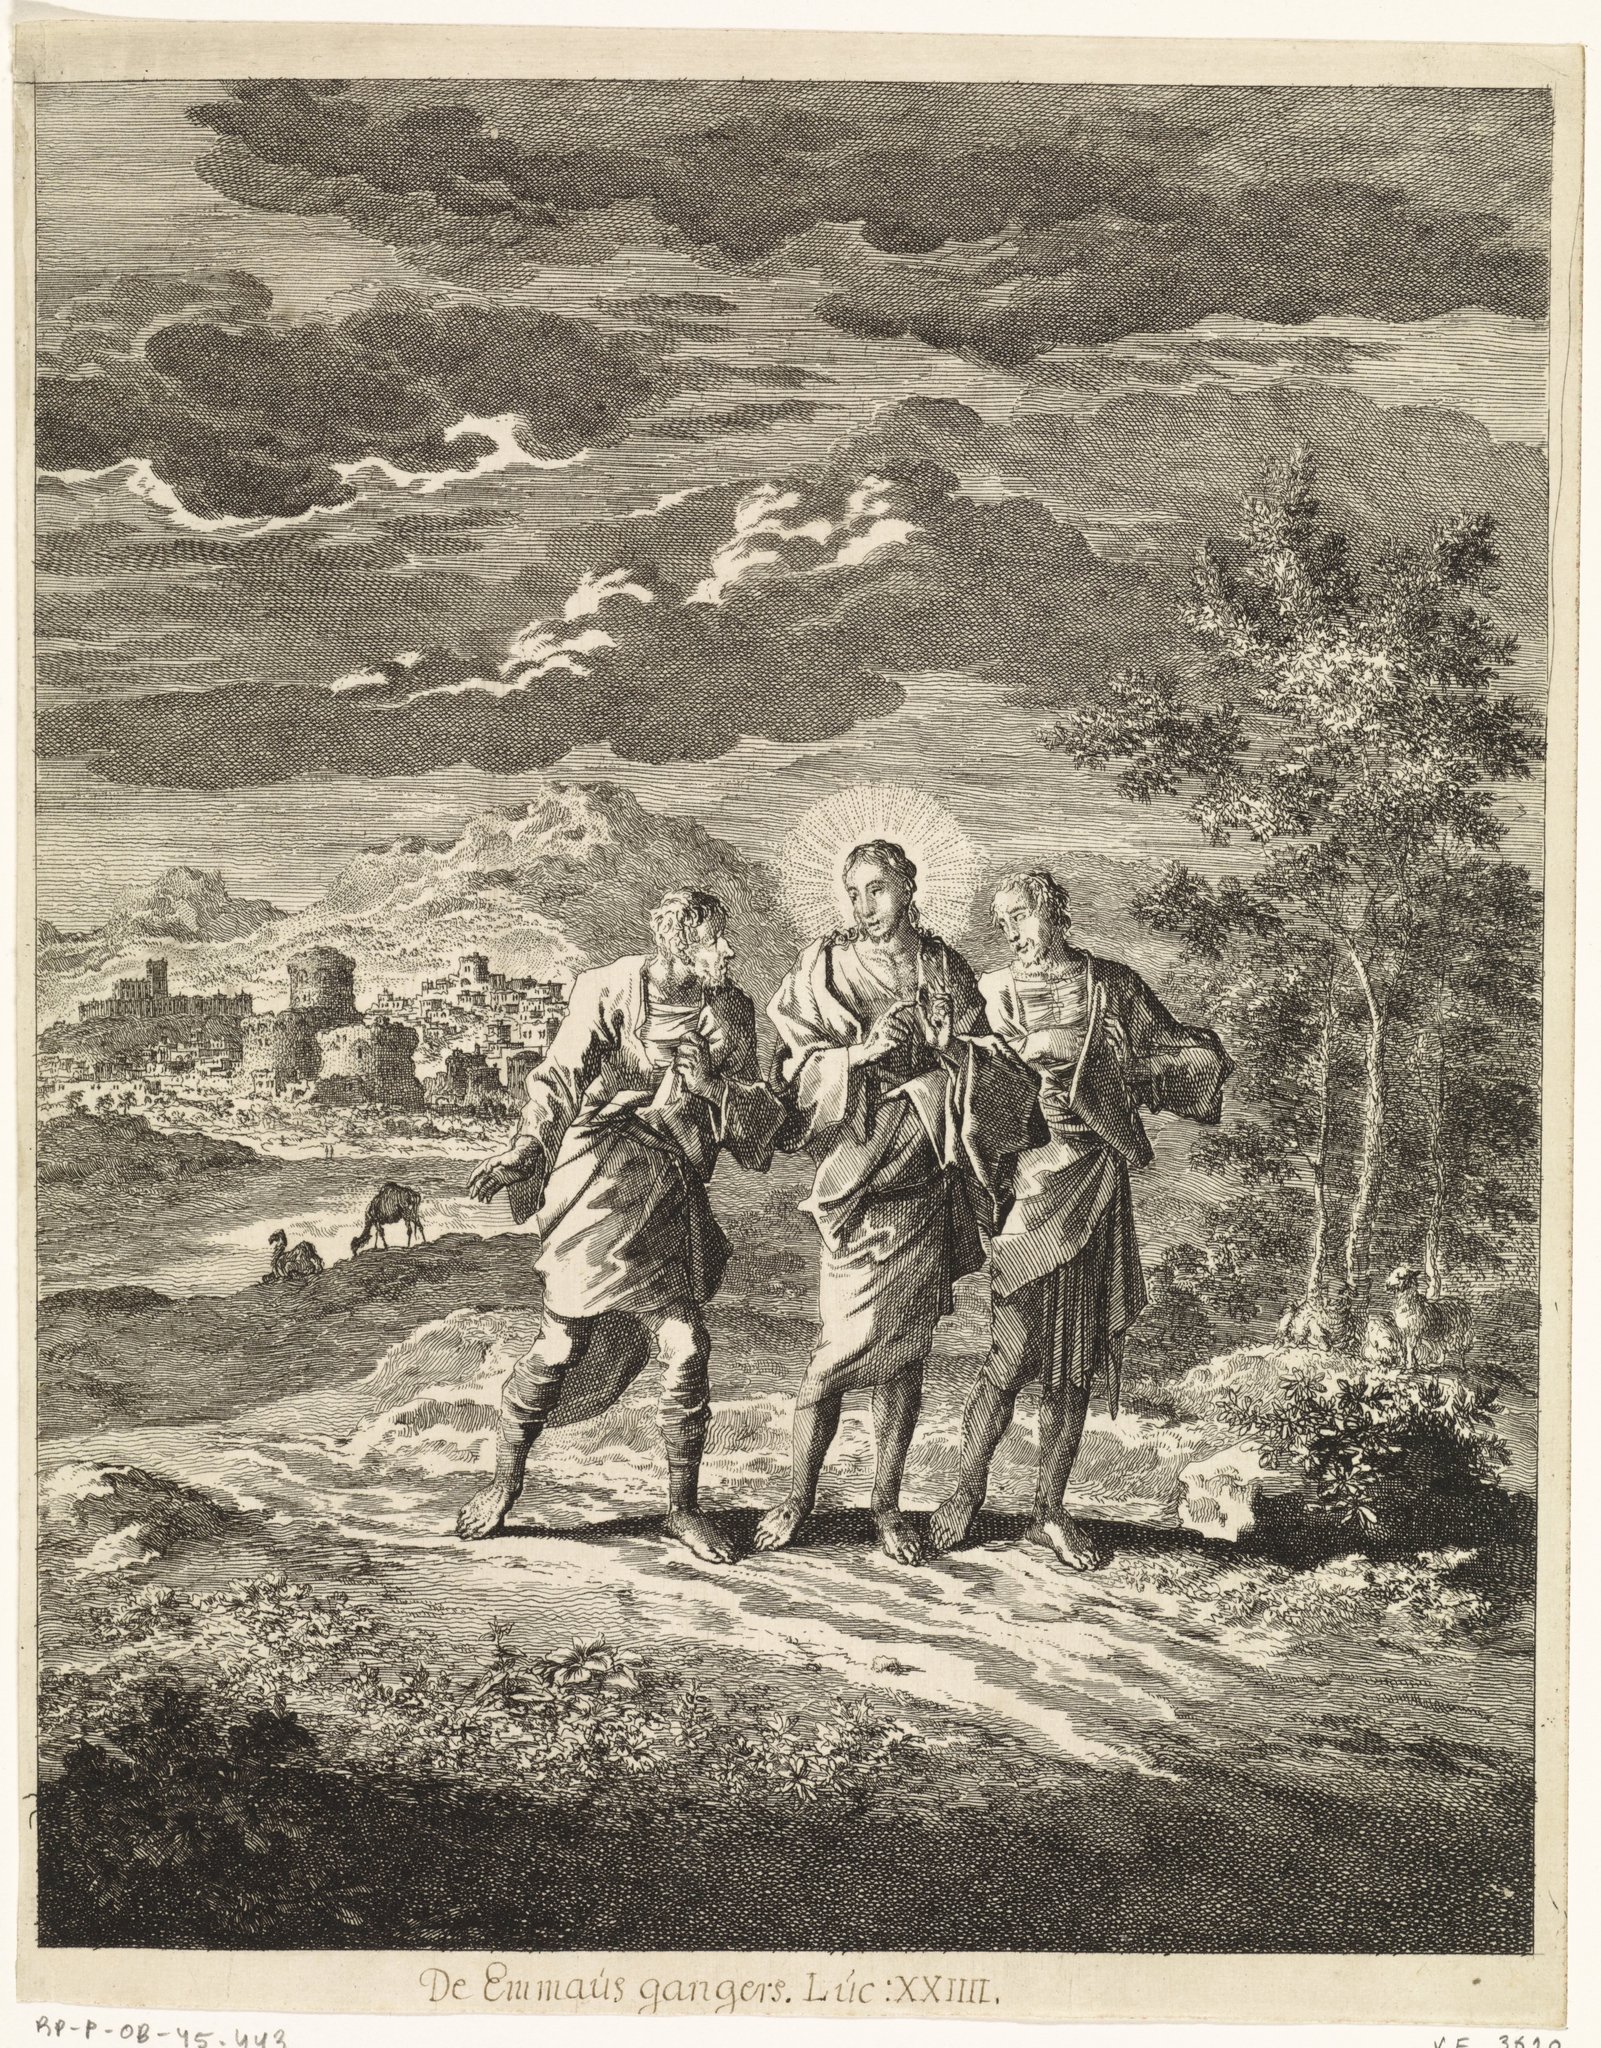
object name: print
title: Emmaüsgangers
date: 1708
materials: paper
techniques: etching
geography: amsterdam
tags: the journey to emmaus: two disciples (cleopas and peter) under way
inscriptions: collector's mark: Lugt 2228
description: Proefdruk van een prent welke is opgenomen als illustratie in: Historiae Celebriores Veteris Testamenti. Christoph Weigel, 1708.